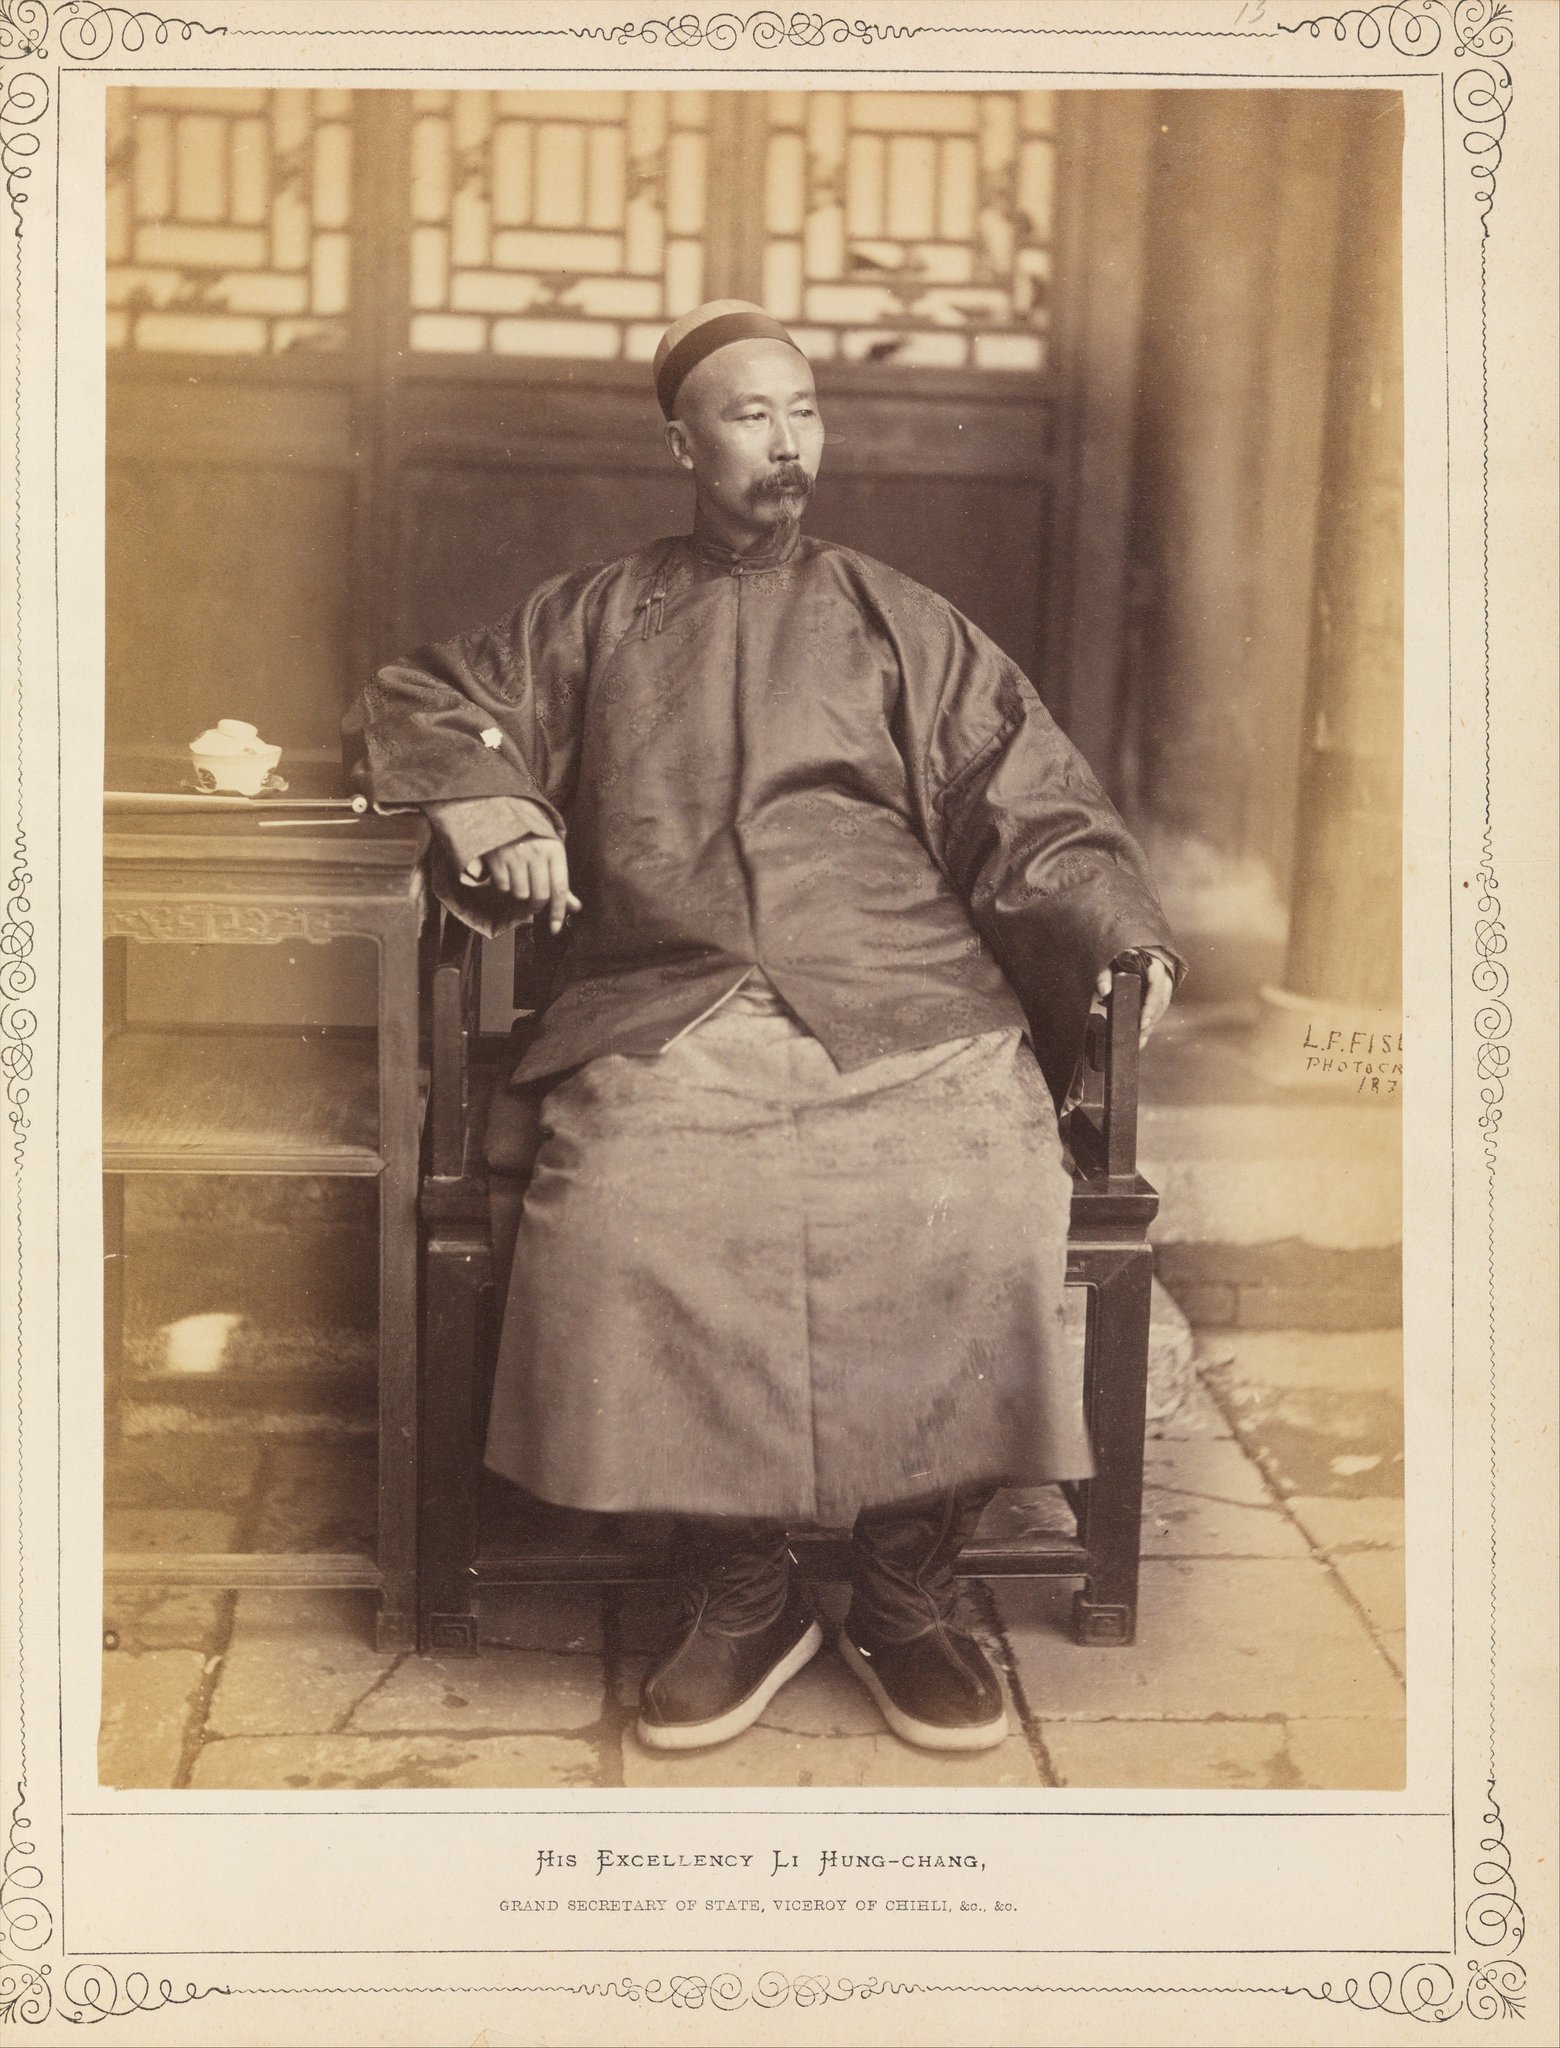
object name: photographically illustrated book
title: The Far East: A Monthly Journal, Illustrated with Photographs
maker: william thomas saunders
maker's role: artist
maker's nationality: british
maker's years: 1832-1892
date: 1870-1879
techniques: albumen silver print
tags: men,portraits